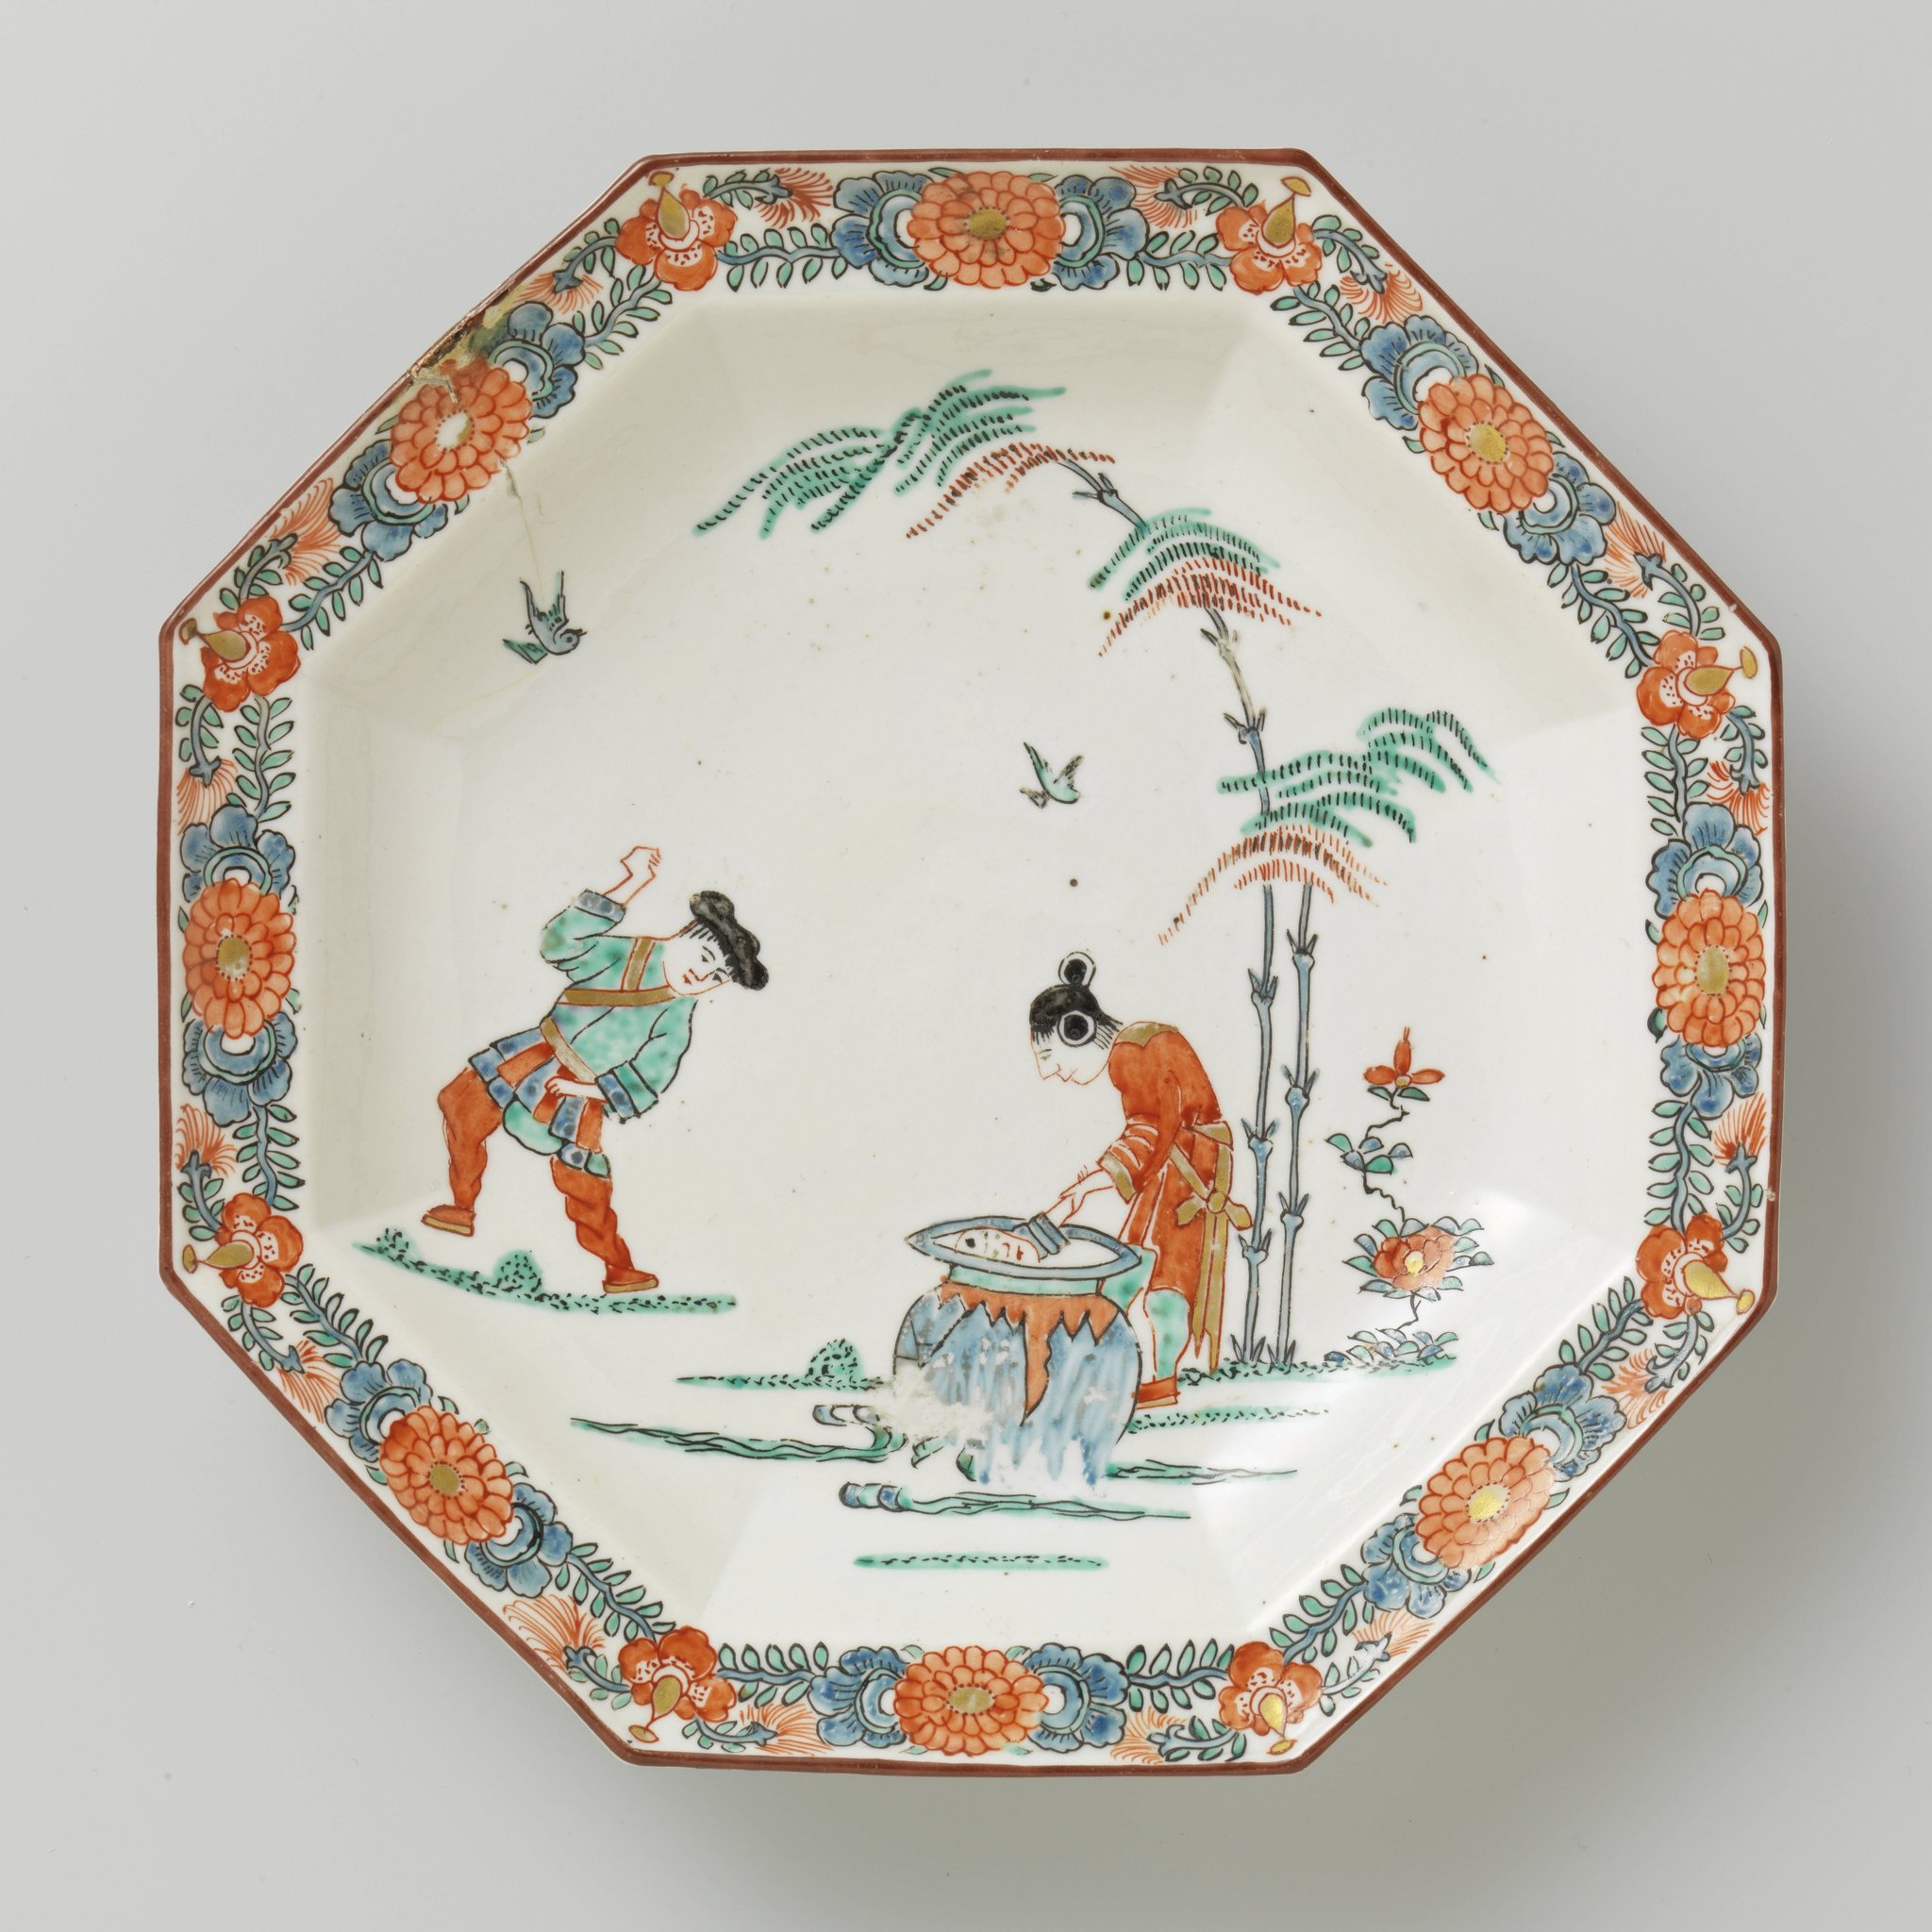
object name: plate dish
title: Octagonal plate with an image of Shiba Onko and floral scrolls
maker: Anonymous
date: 1730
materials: glaze, gold, paint, porcelain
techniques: firing, forming, gilding, turning, vitrification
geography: arita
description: Achthoekig bord van porselein, beschilderd op het glazuur in blauw, rood, groen, zwart en goud. Op het plat een voorstelling van Shiba Onko (Sima Guang) naast de waterpot waar een kind in is gevallen. Een derde persoon staat aan de andere zijde van de pot. Op de rand een band met bloemranken. Drie proenen op de onderzijde. Een barst in de rand. Arita, in Europa gedecoreerd in de Japanse Kakiemon-stijl.